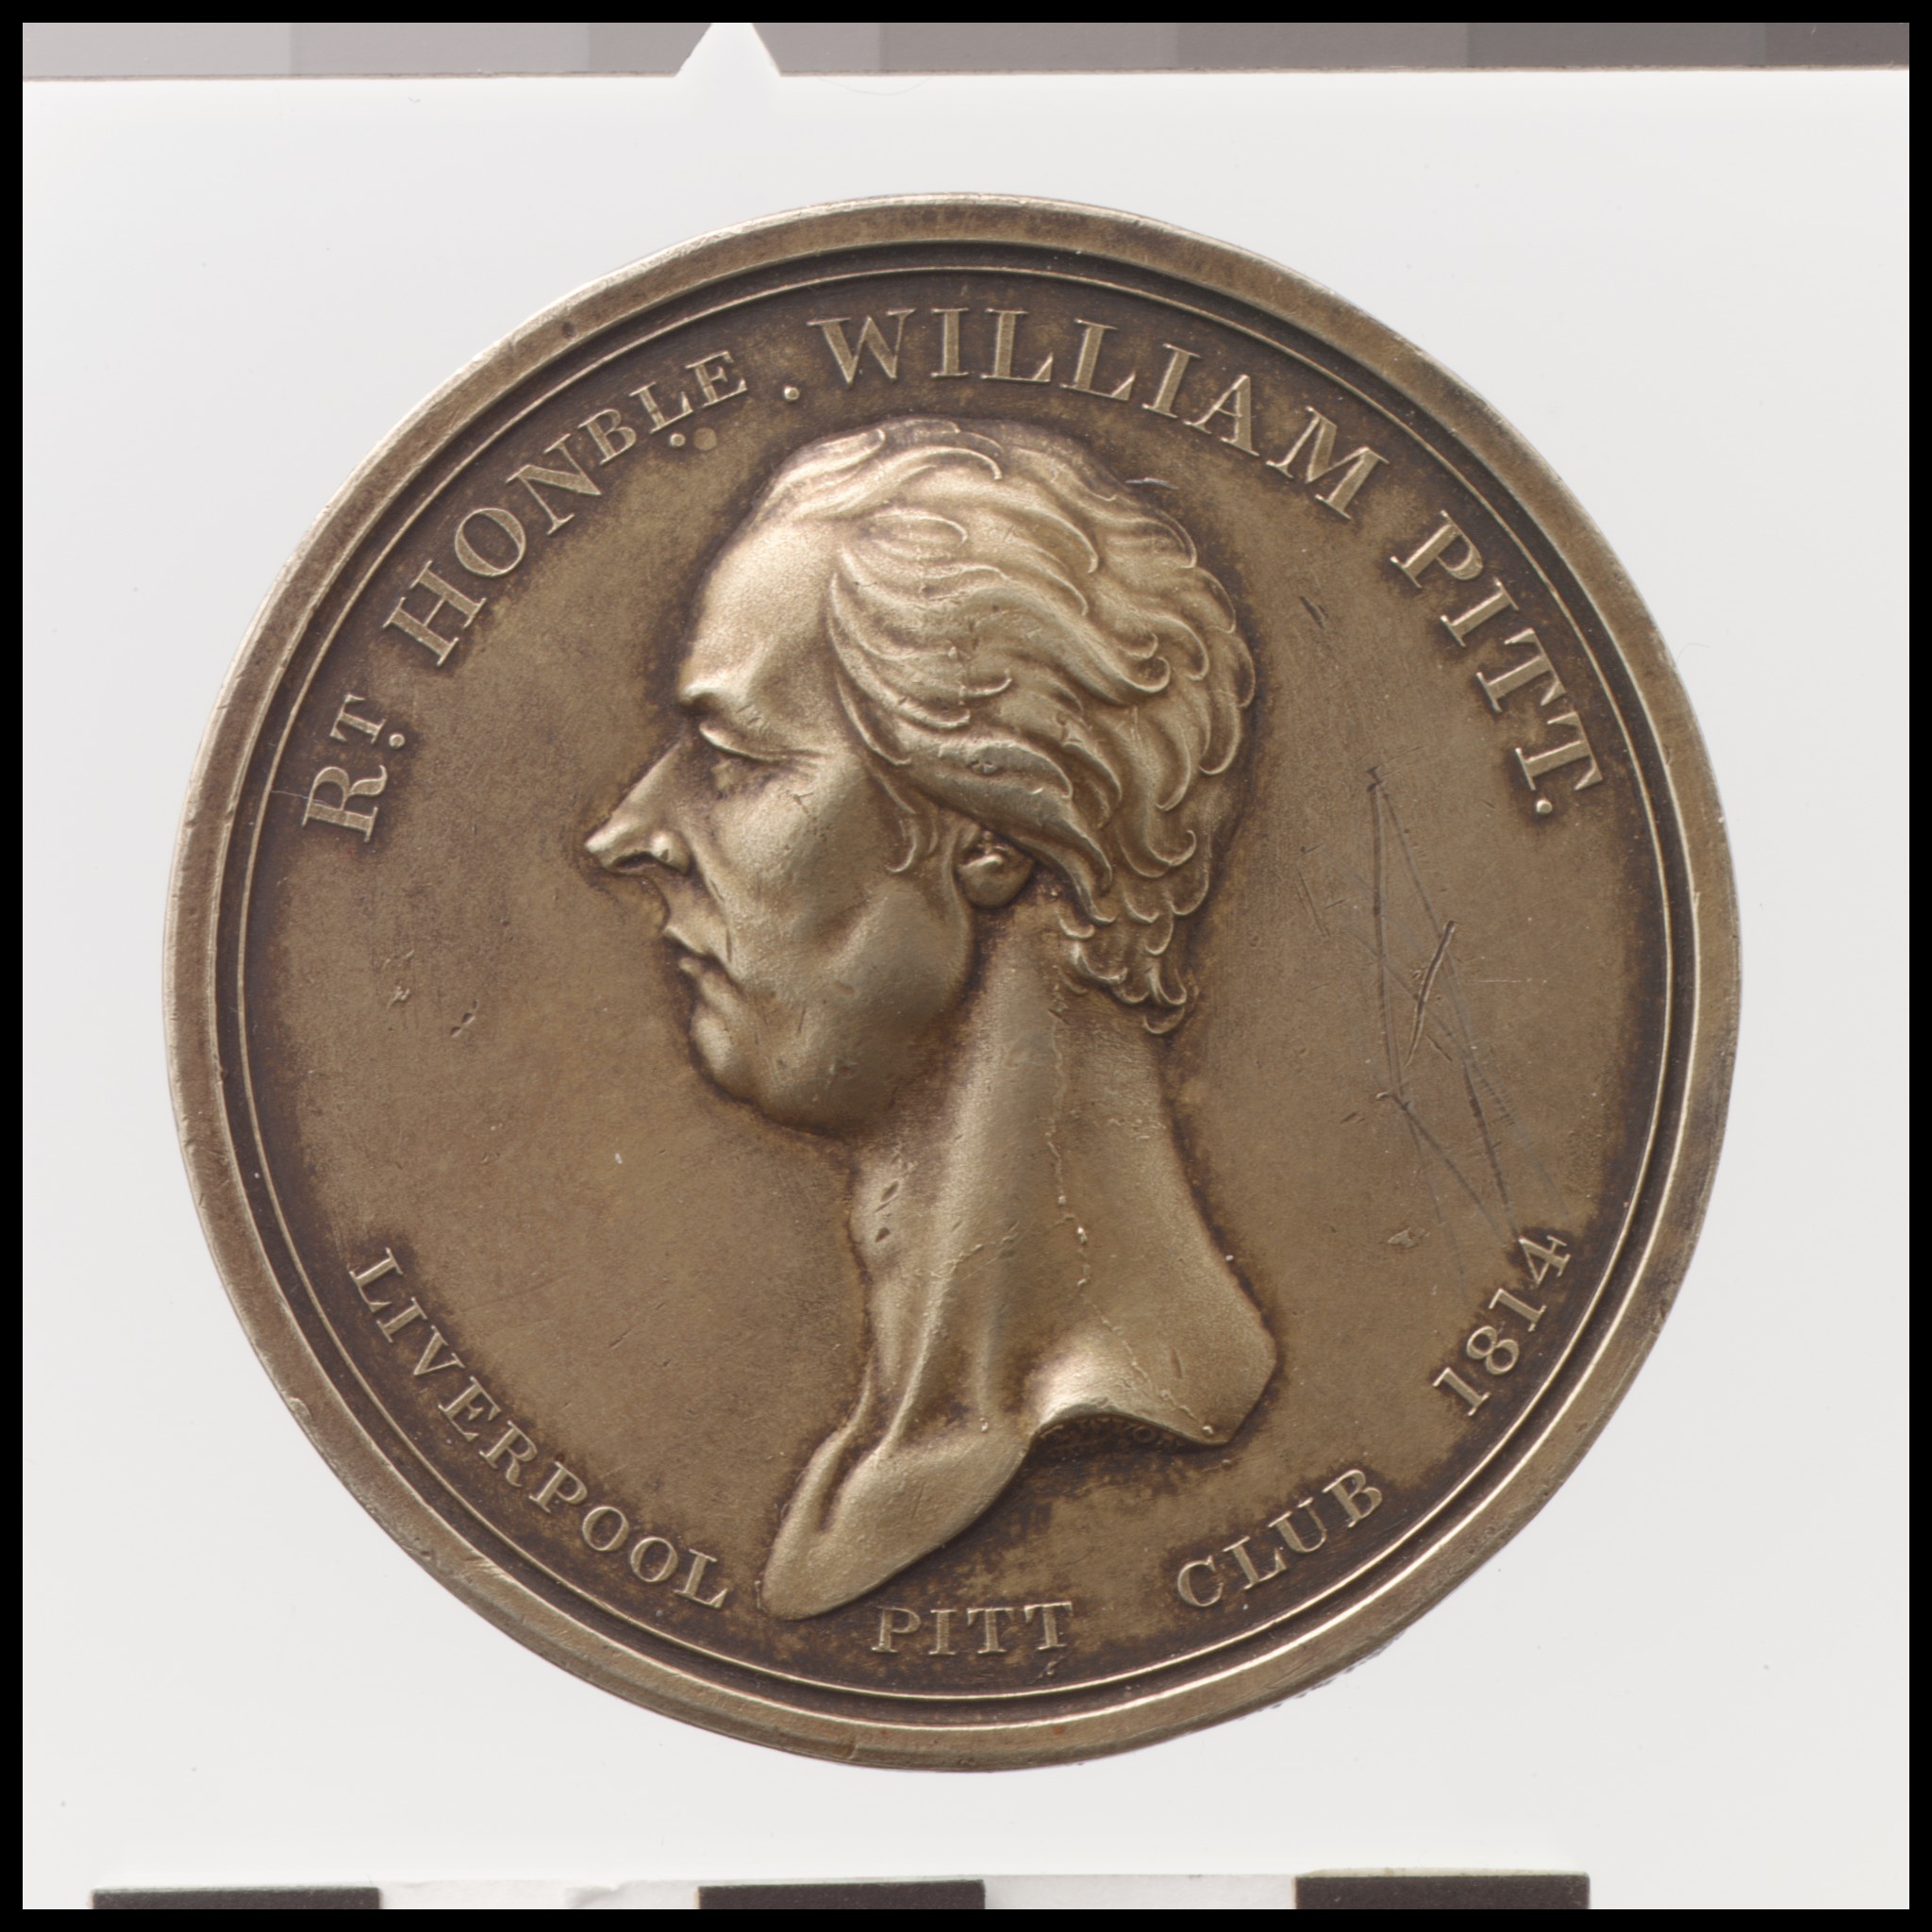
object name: medal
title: William Pitt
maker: thomas wyon the younger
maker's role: artist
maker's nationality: british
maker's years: 1791-1817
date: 1814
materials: bronze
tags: men,profiles,wreaths